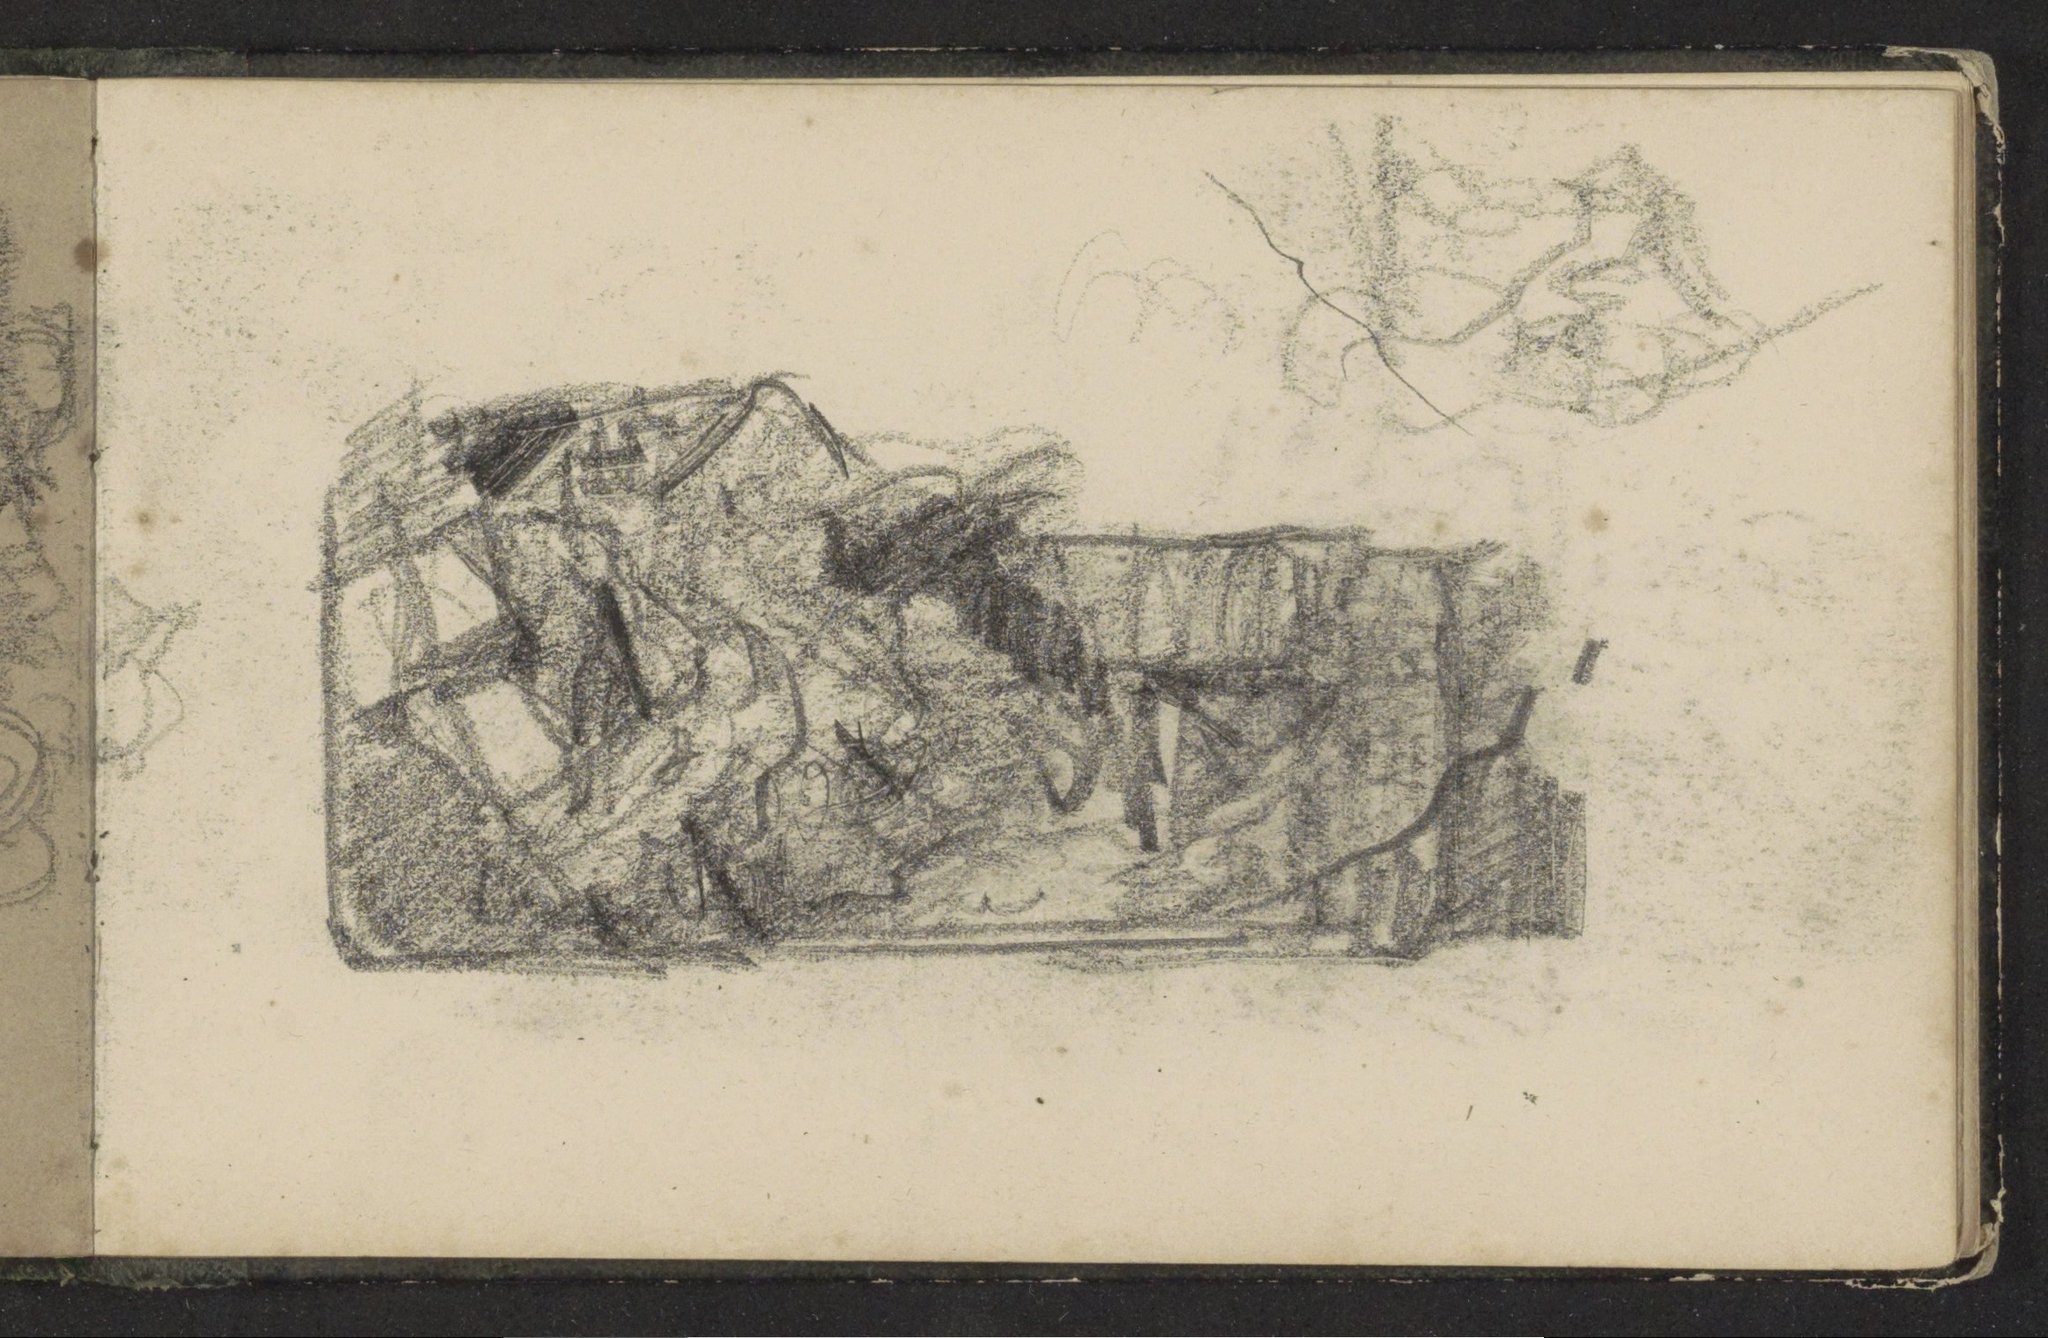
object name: sketchbook leaf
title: Plattelandshuis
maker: maria vos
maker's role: draughtsman, painter, print maker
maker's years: 1824-1906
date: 1856-1870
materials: paper, pencil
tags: rural housing, e.g. country-house, villa, cottage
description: Blad 31 recto uit een schetsboek met 39 bladen.